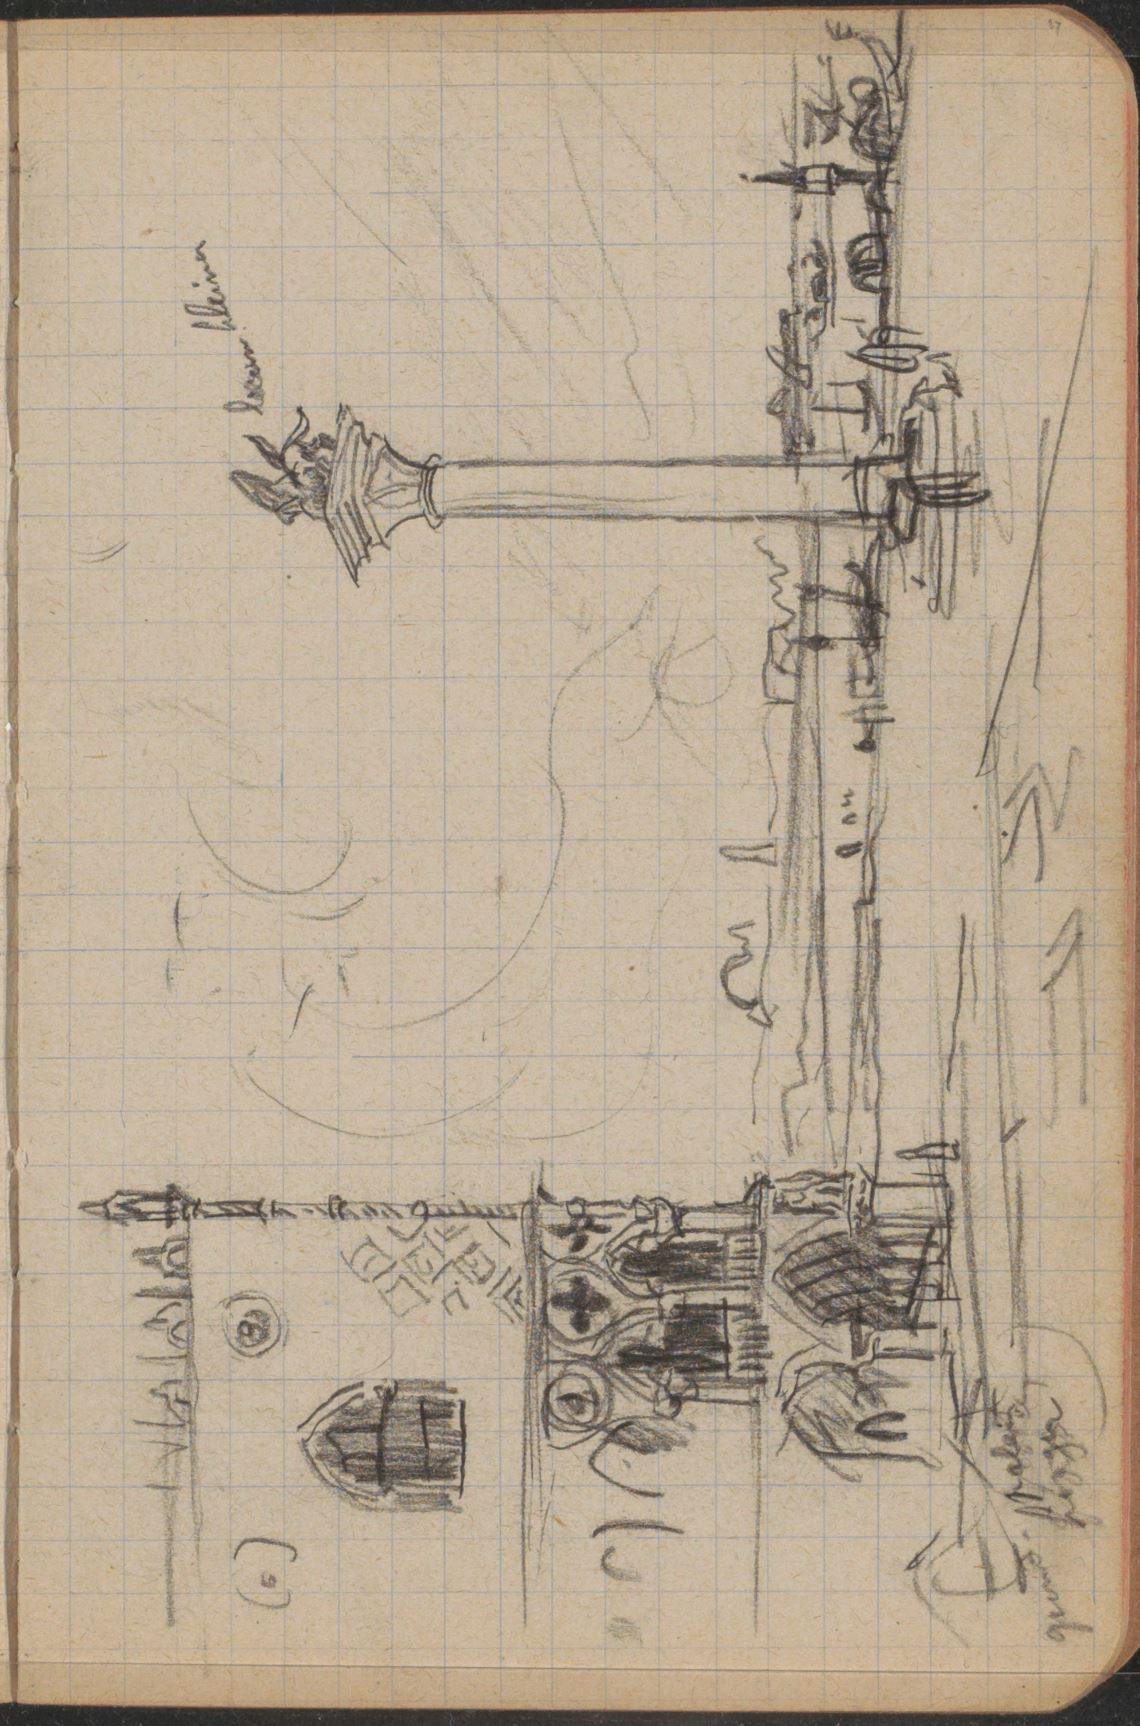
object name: sketchbook leaf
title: Hoek van het San Marco Plein met het Dogenpaleis en de zuil met de Leeuw van Venetië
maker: marius bauer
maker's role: draughtsman, print maker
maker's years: 1867-1932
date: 1895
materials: chalk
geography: venice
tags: column, pillar ~ architecture, palace, sculpture, street (+ city(-scape) with figures, staffage)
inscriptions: annotation: ‘leeuw kleiner/ gra[...]nd paleis,/ Loggia’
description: Op deze hoek kruisen het San Marco plein en de Riva degli Schiavone elkaar bij het water. Pagina 17 uit een schetsboek met 28 bladen.